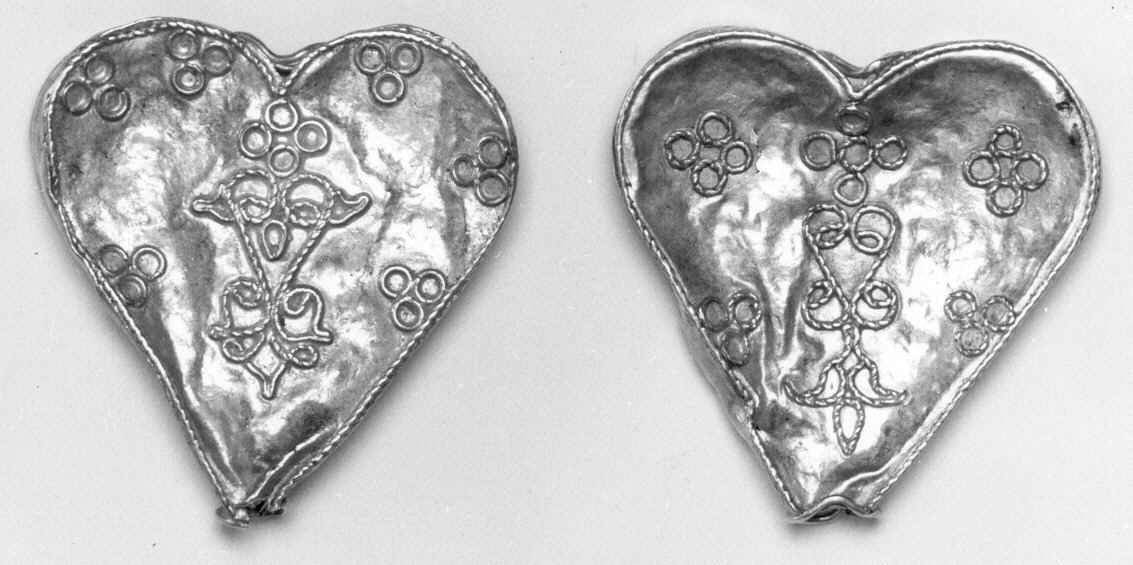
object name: element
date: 1001-1200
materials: gold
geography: iran